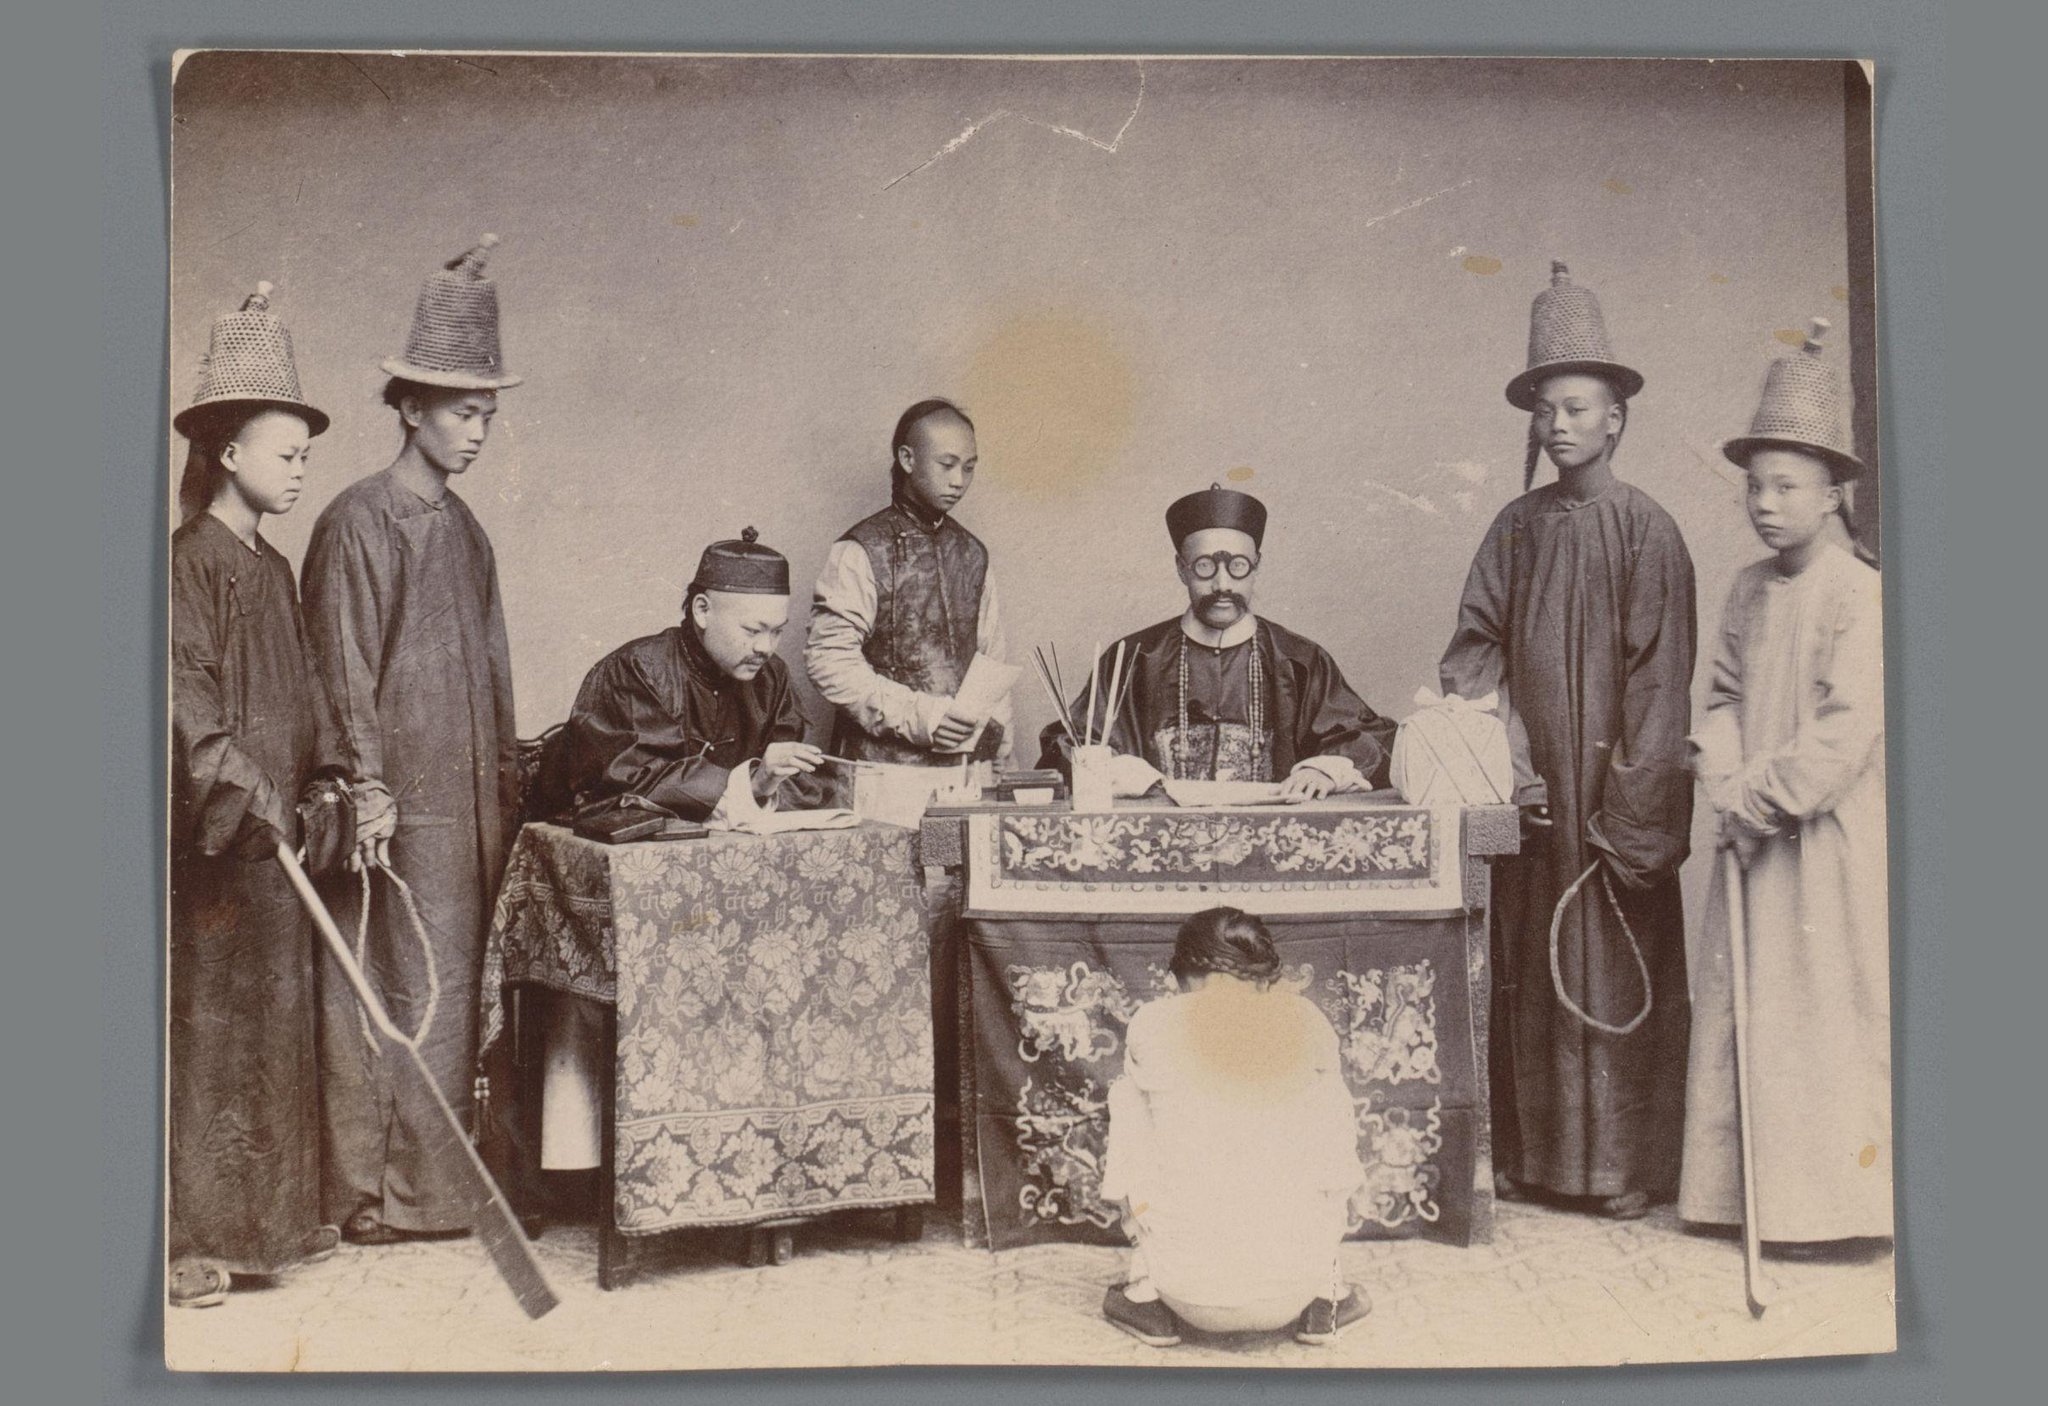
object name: photograph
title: Vrouw voor een rechtbank, China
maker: Anonymous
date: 1880-1900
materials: paper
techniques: gelatin silver print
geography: china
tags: court session (court of justice), china